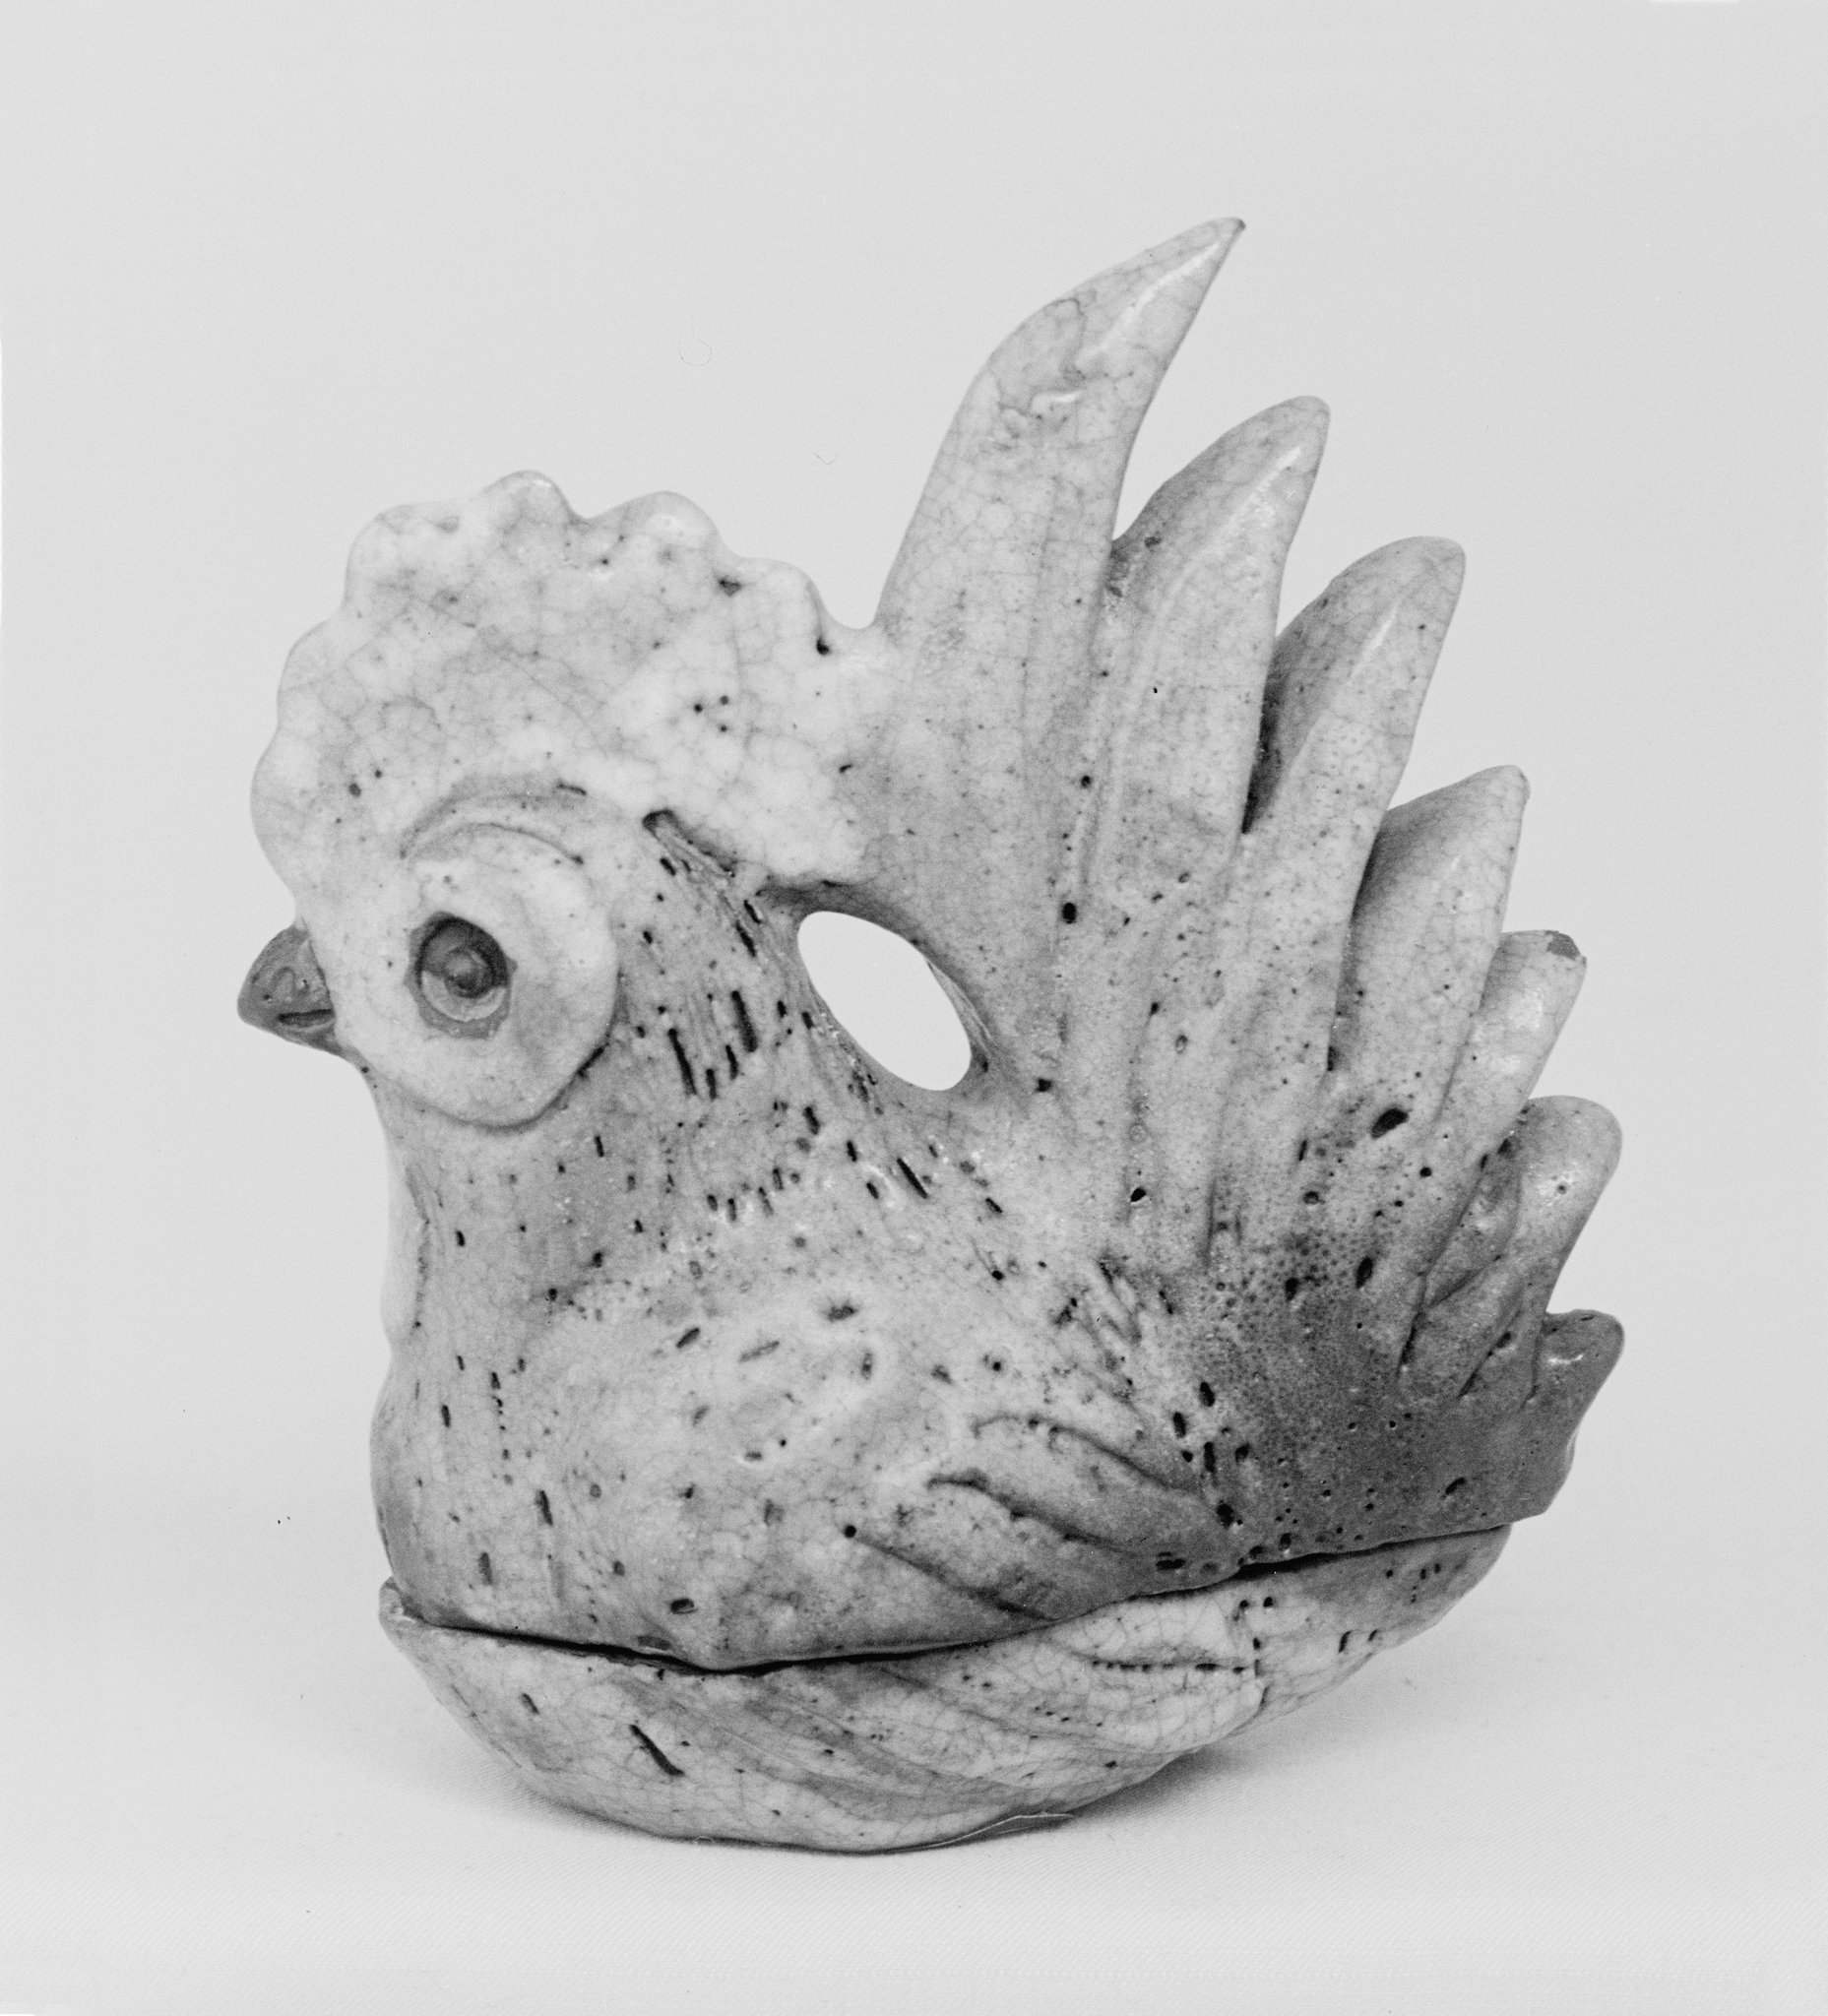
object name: incense box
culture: japanese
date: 1701-1800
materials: clay, glaze, paste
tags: roosters